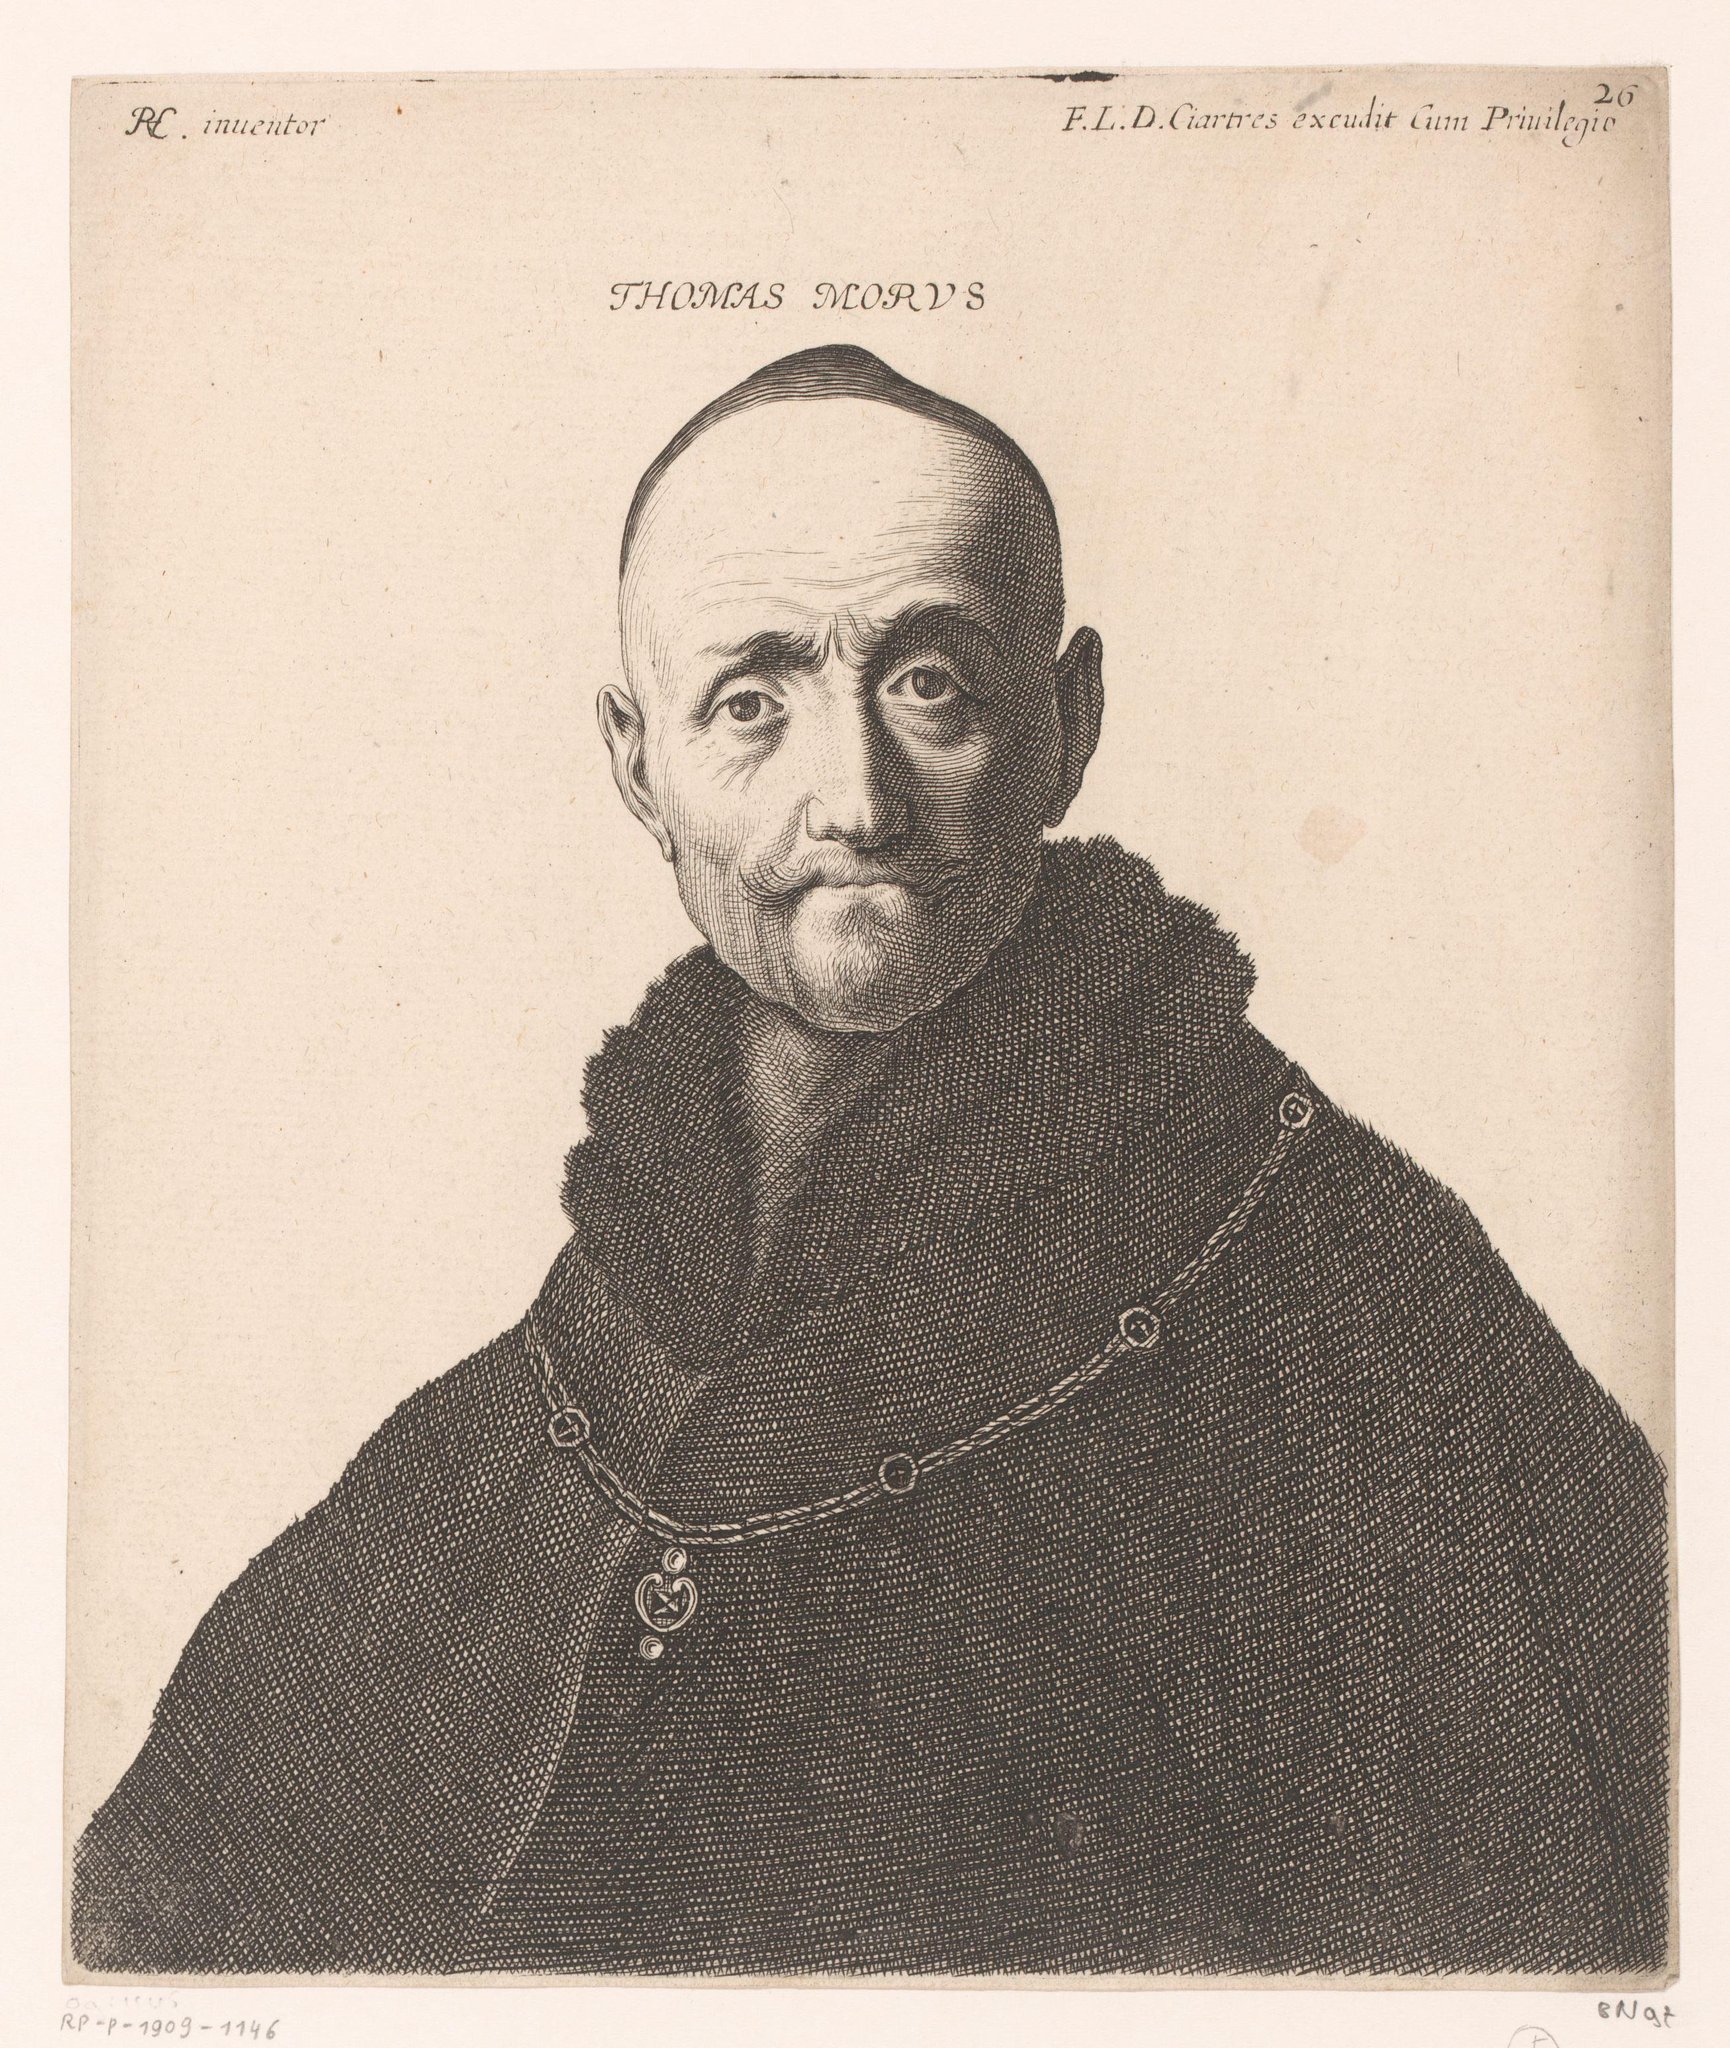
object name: print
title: Bustes van filosofen en koningen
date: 1615-1647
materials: paper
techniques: engraving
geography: paris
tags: london, scholar, philosopher, portrait of a writer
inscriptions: collector's mark: Lugt 2228